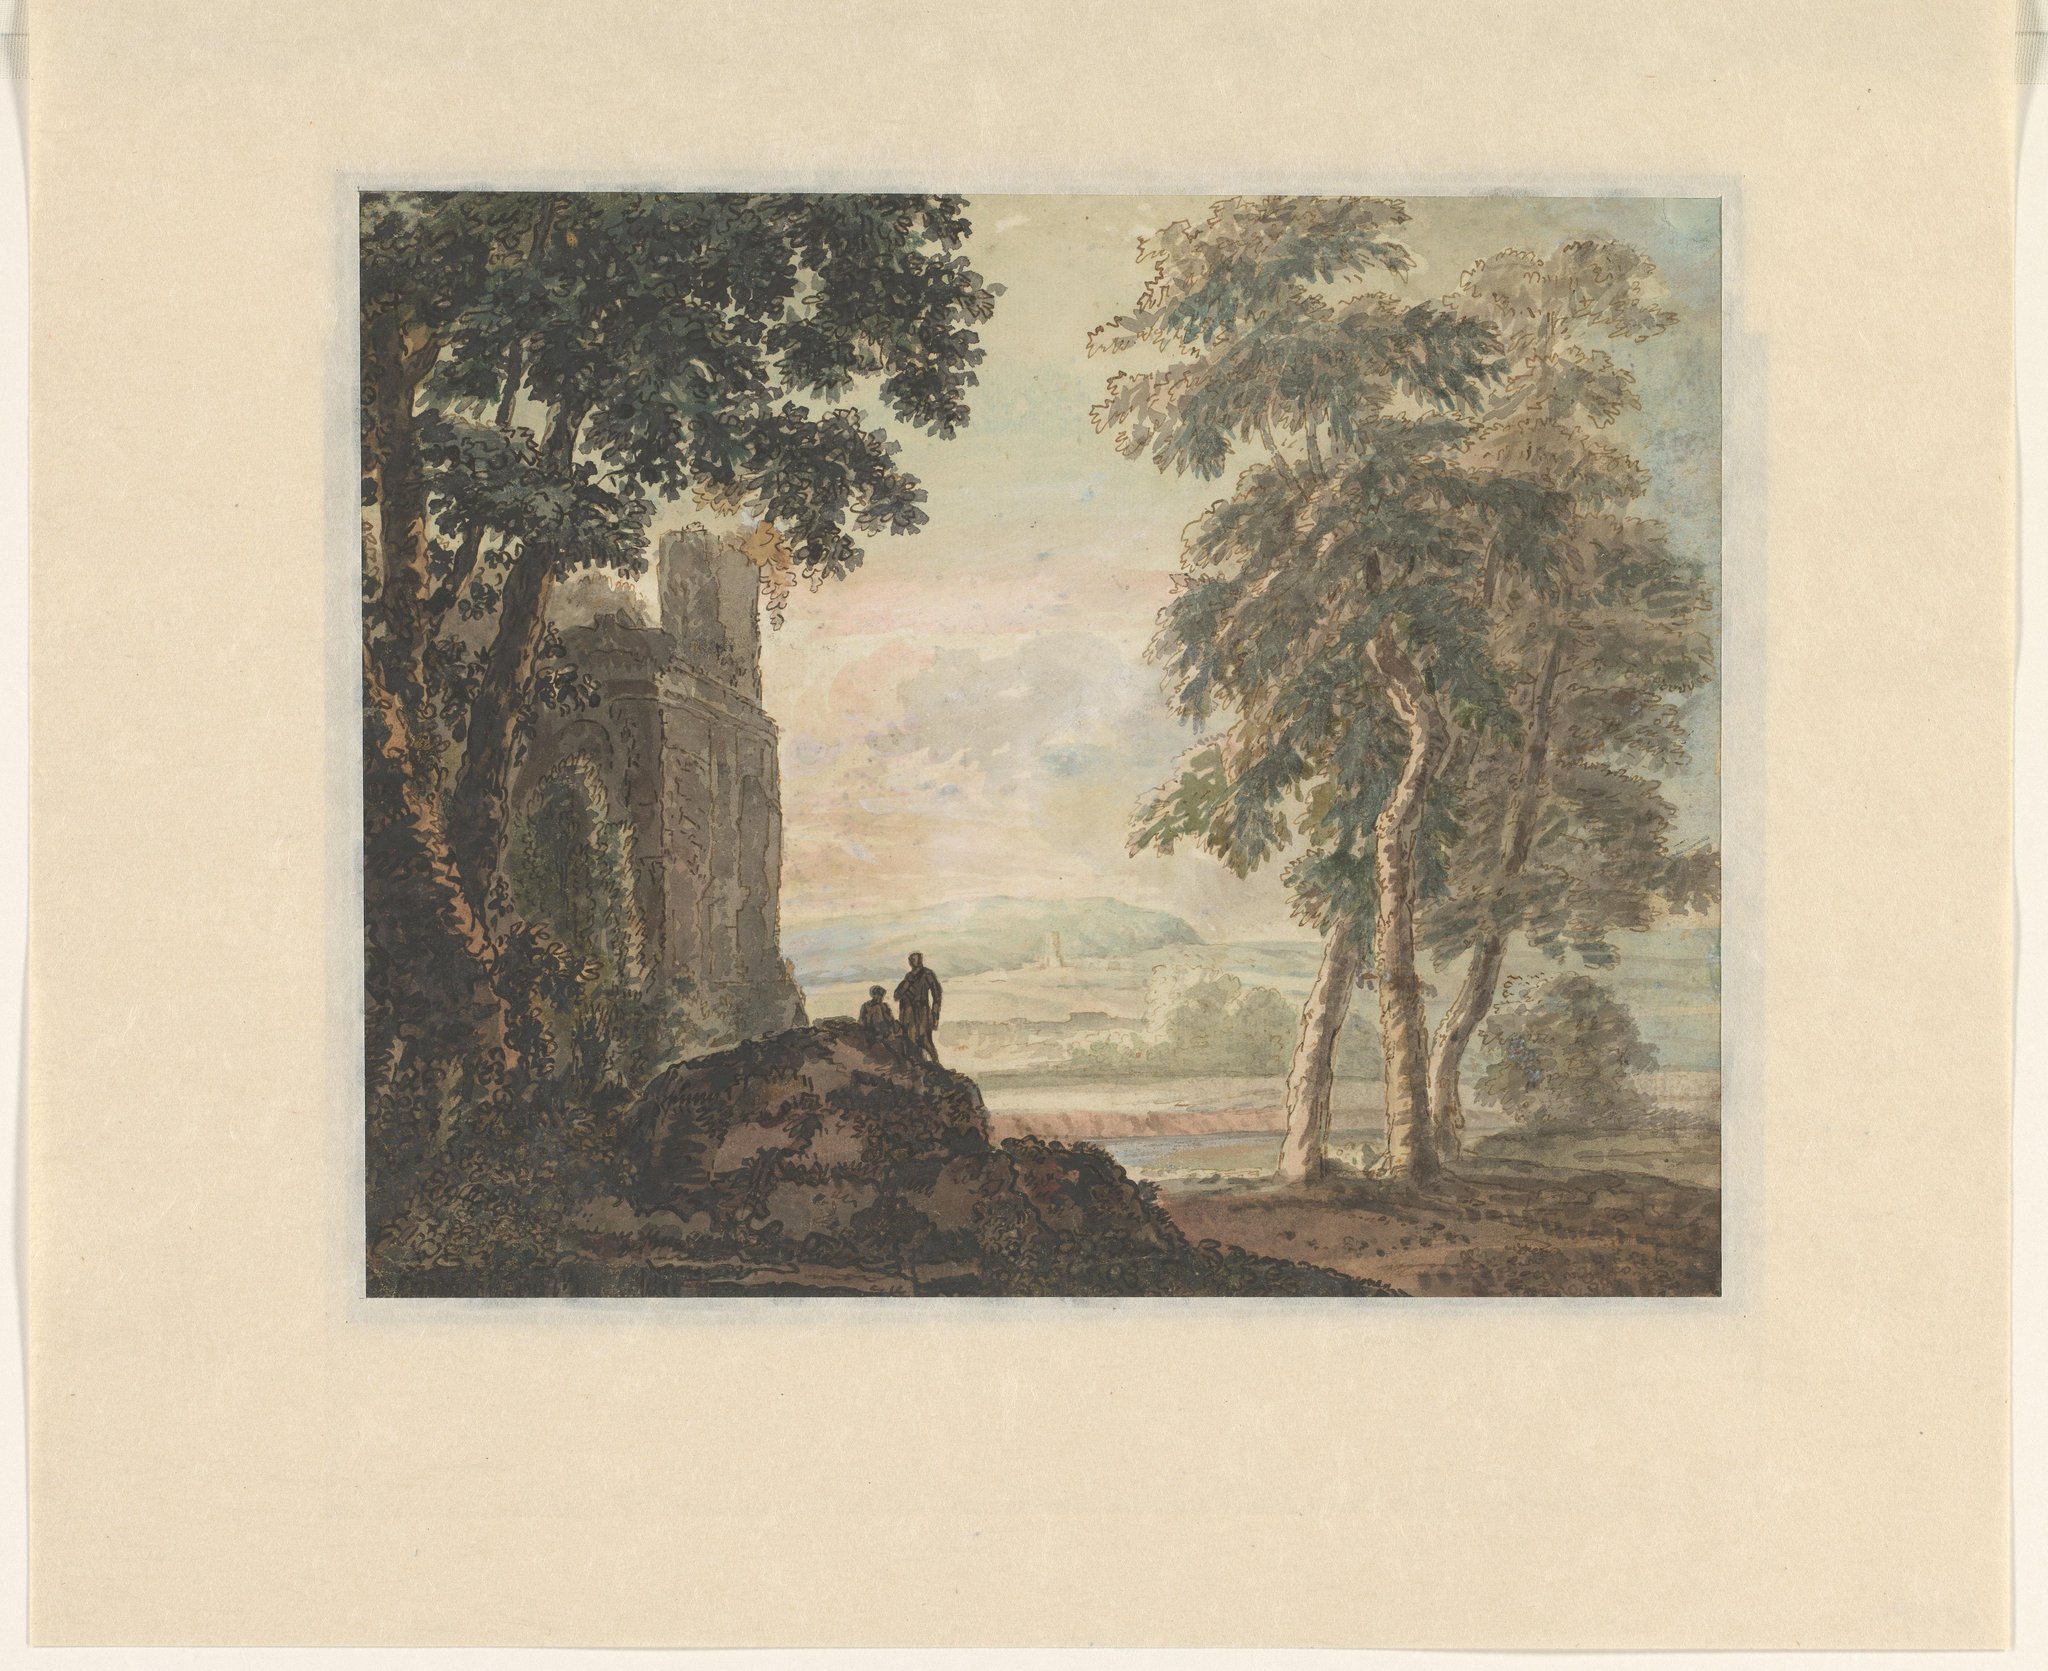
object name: watercolor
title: Arcadisch landschap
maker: jacob van liender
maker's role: draughtsman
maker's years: 1696-1759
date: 1706-1759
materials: ink, paper, watercolor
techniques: brush, pen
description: Arcadisch landschap op de voorzijde, doorgetrokken met enkele wijzigingen.